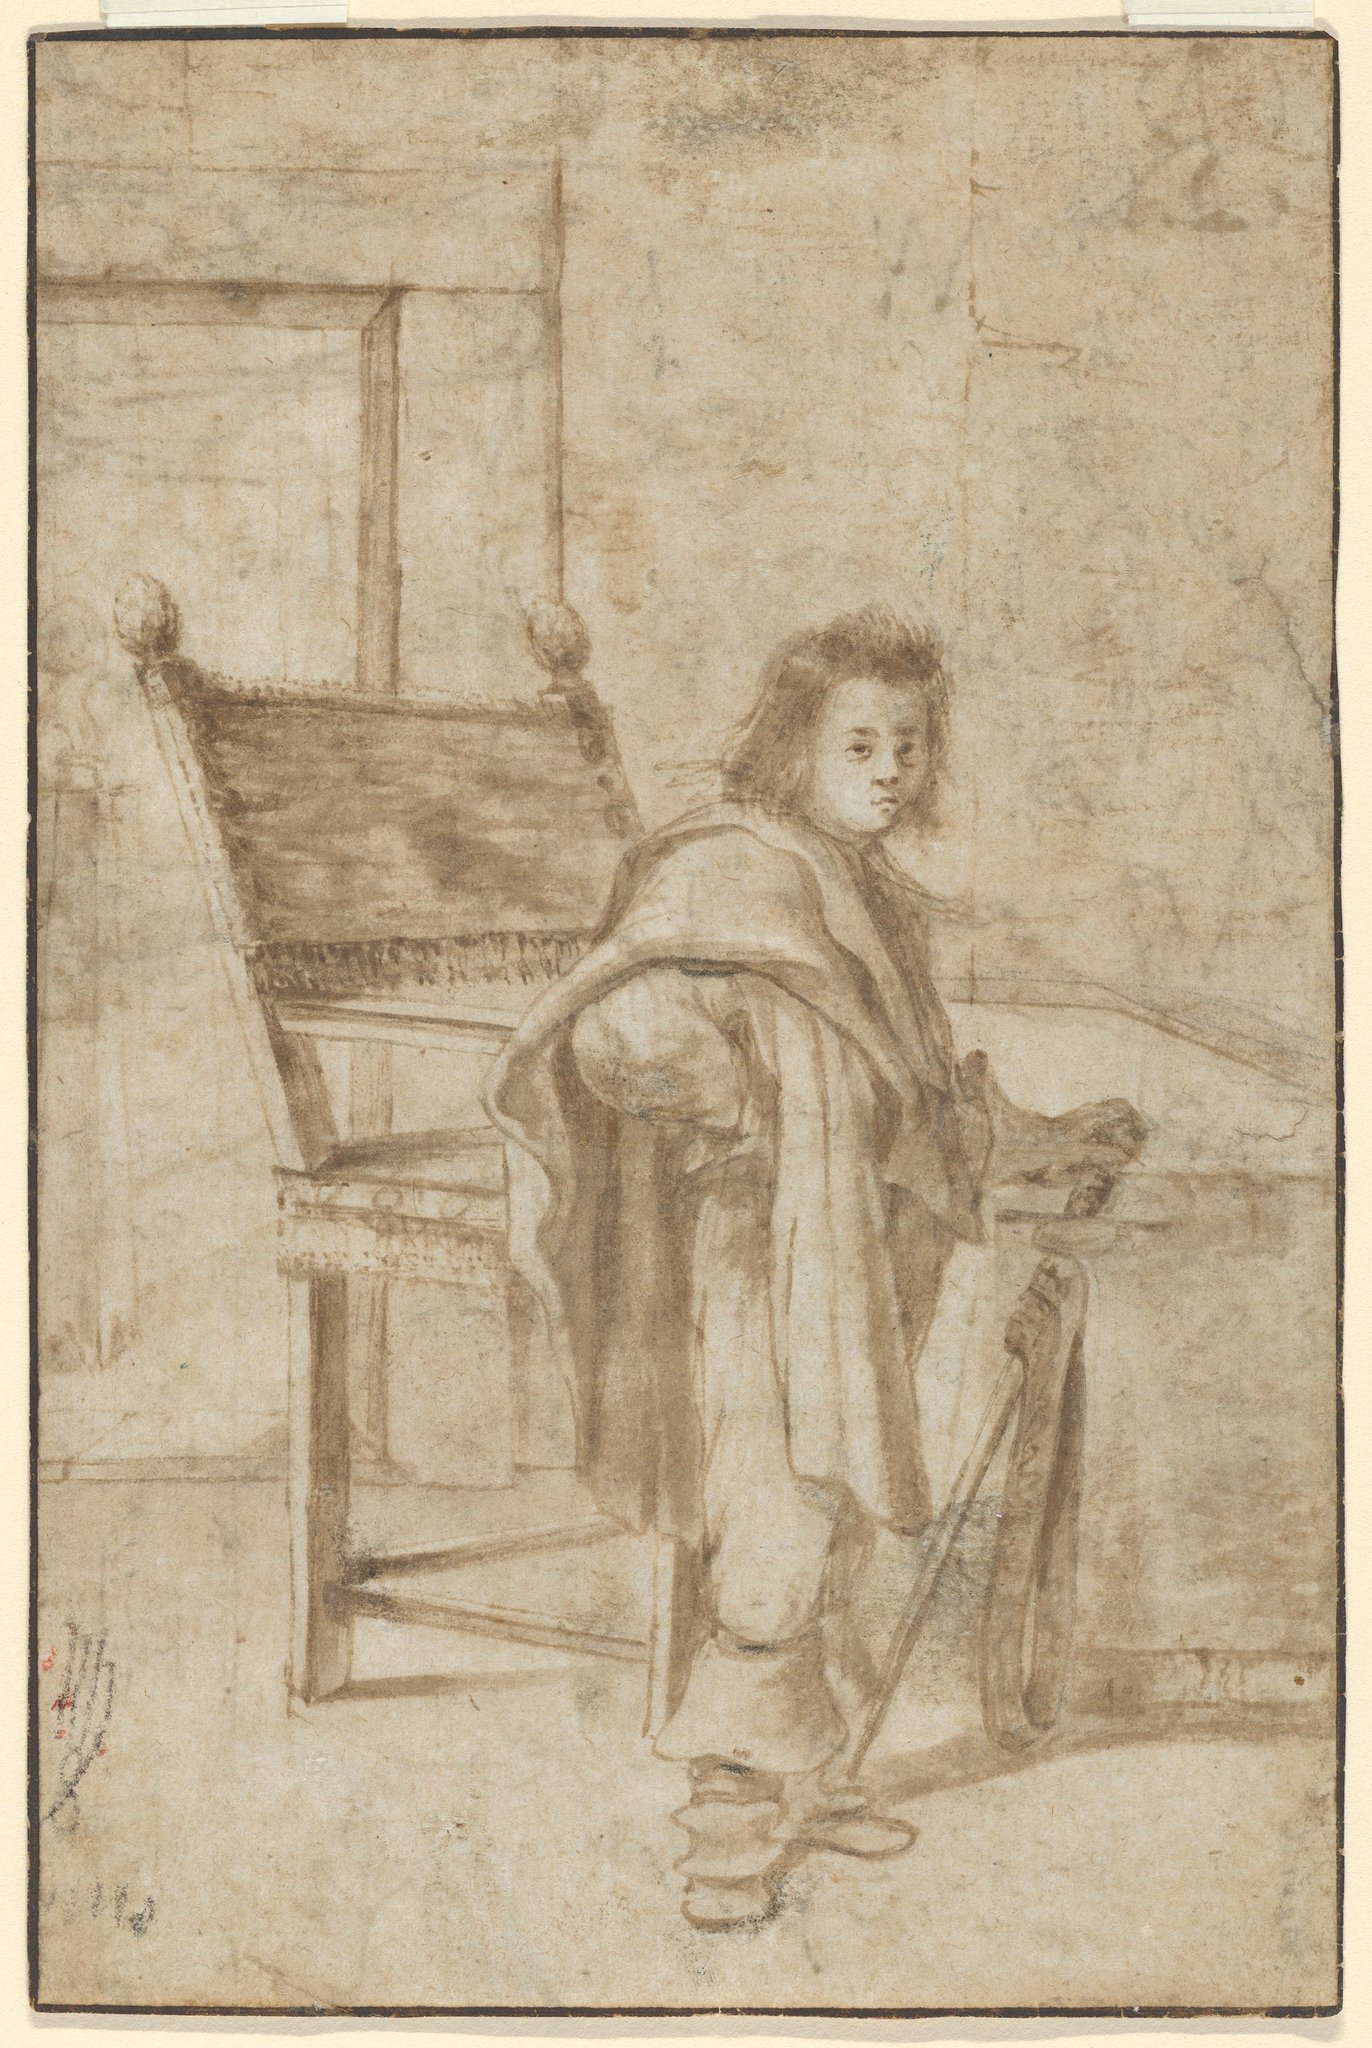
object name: drawing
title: Boy Holding a Sword, Standing near a Table in an Interior (recto); Various Sketches of Figures and Ornamental Forms (verso)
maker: anonymous, dutch, 17th century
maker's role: artist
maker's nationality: dutch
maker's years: 1600-1700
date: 1601-1700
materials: chalk, ink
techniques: brush, pen, wash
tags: swords,boys,tables